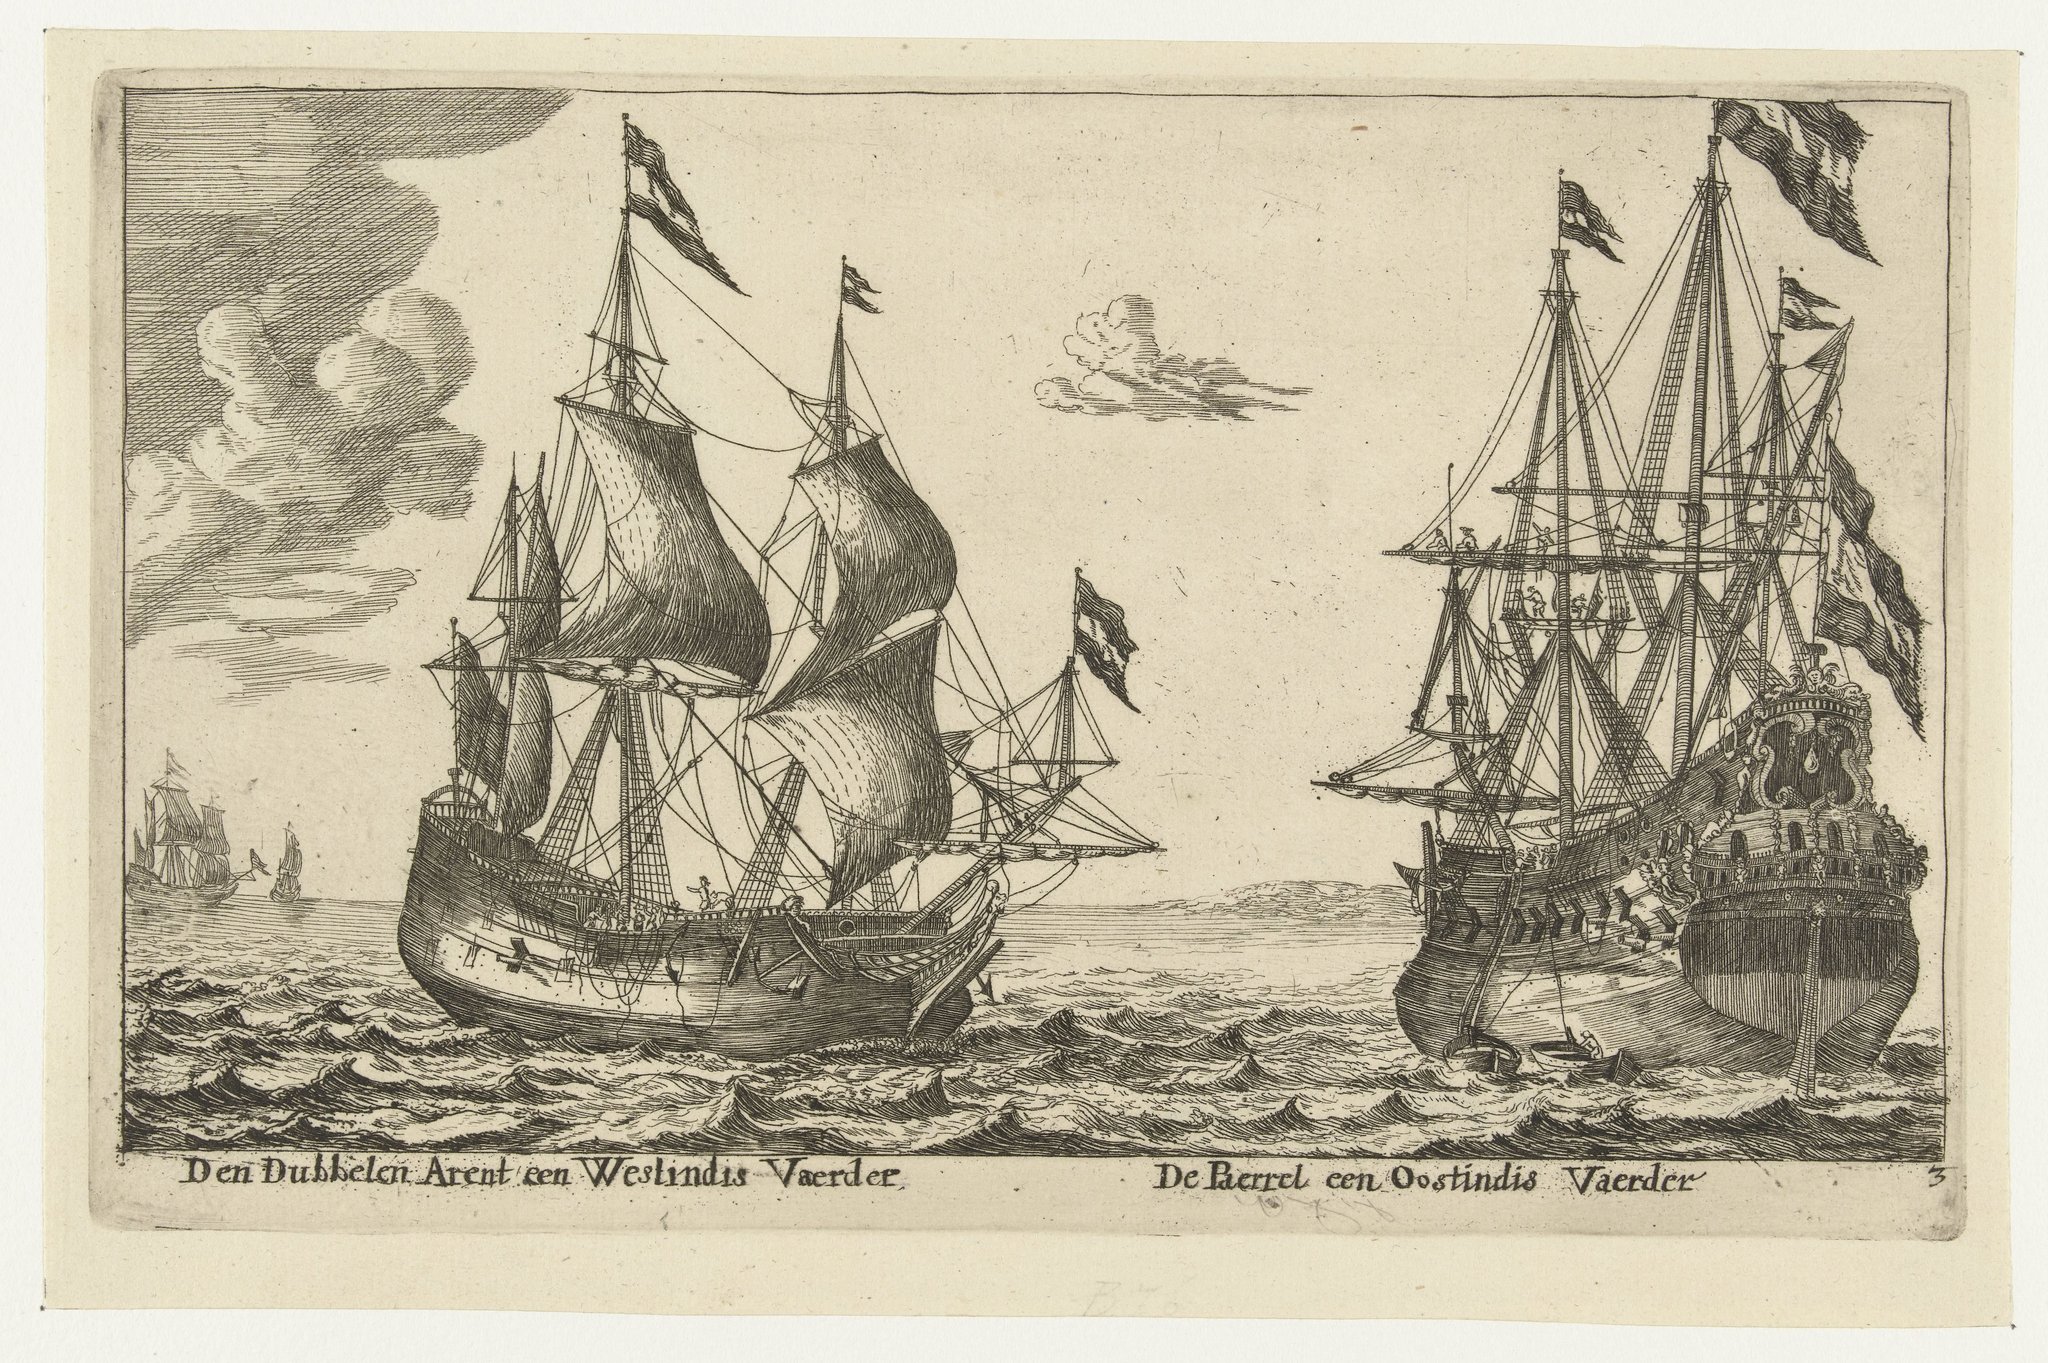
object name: print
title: De schepen De Parel en De Dubbele Arend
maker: Anonymous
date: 1652-1714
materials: paper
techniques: etching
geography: netherlands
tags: sailing-ship, sailing-boat (eastindiaman), sailing-ship, sailing-boat (westindiaman)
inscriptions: collector's mark: Lugt 2228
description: Kopie in spiegelbeeld. Twee koopvaardijschepen op zee vlak bij land. Links De Dubbele Arend, een West-indiëvaarder en rechts De Parel, een Oost-indiëvaarder.